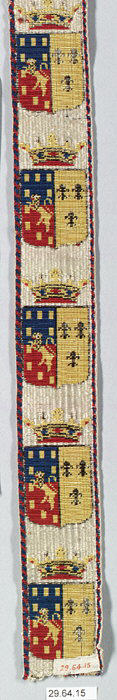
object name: galloon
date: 1701-1900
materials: silk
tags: coat of arms